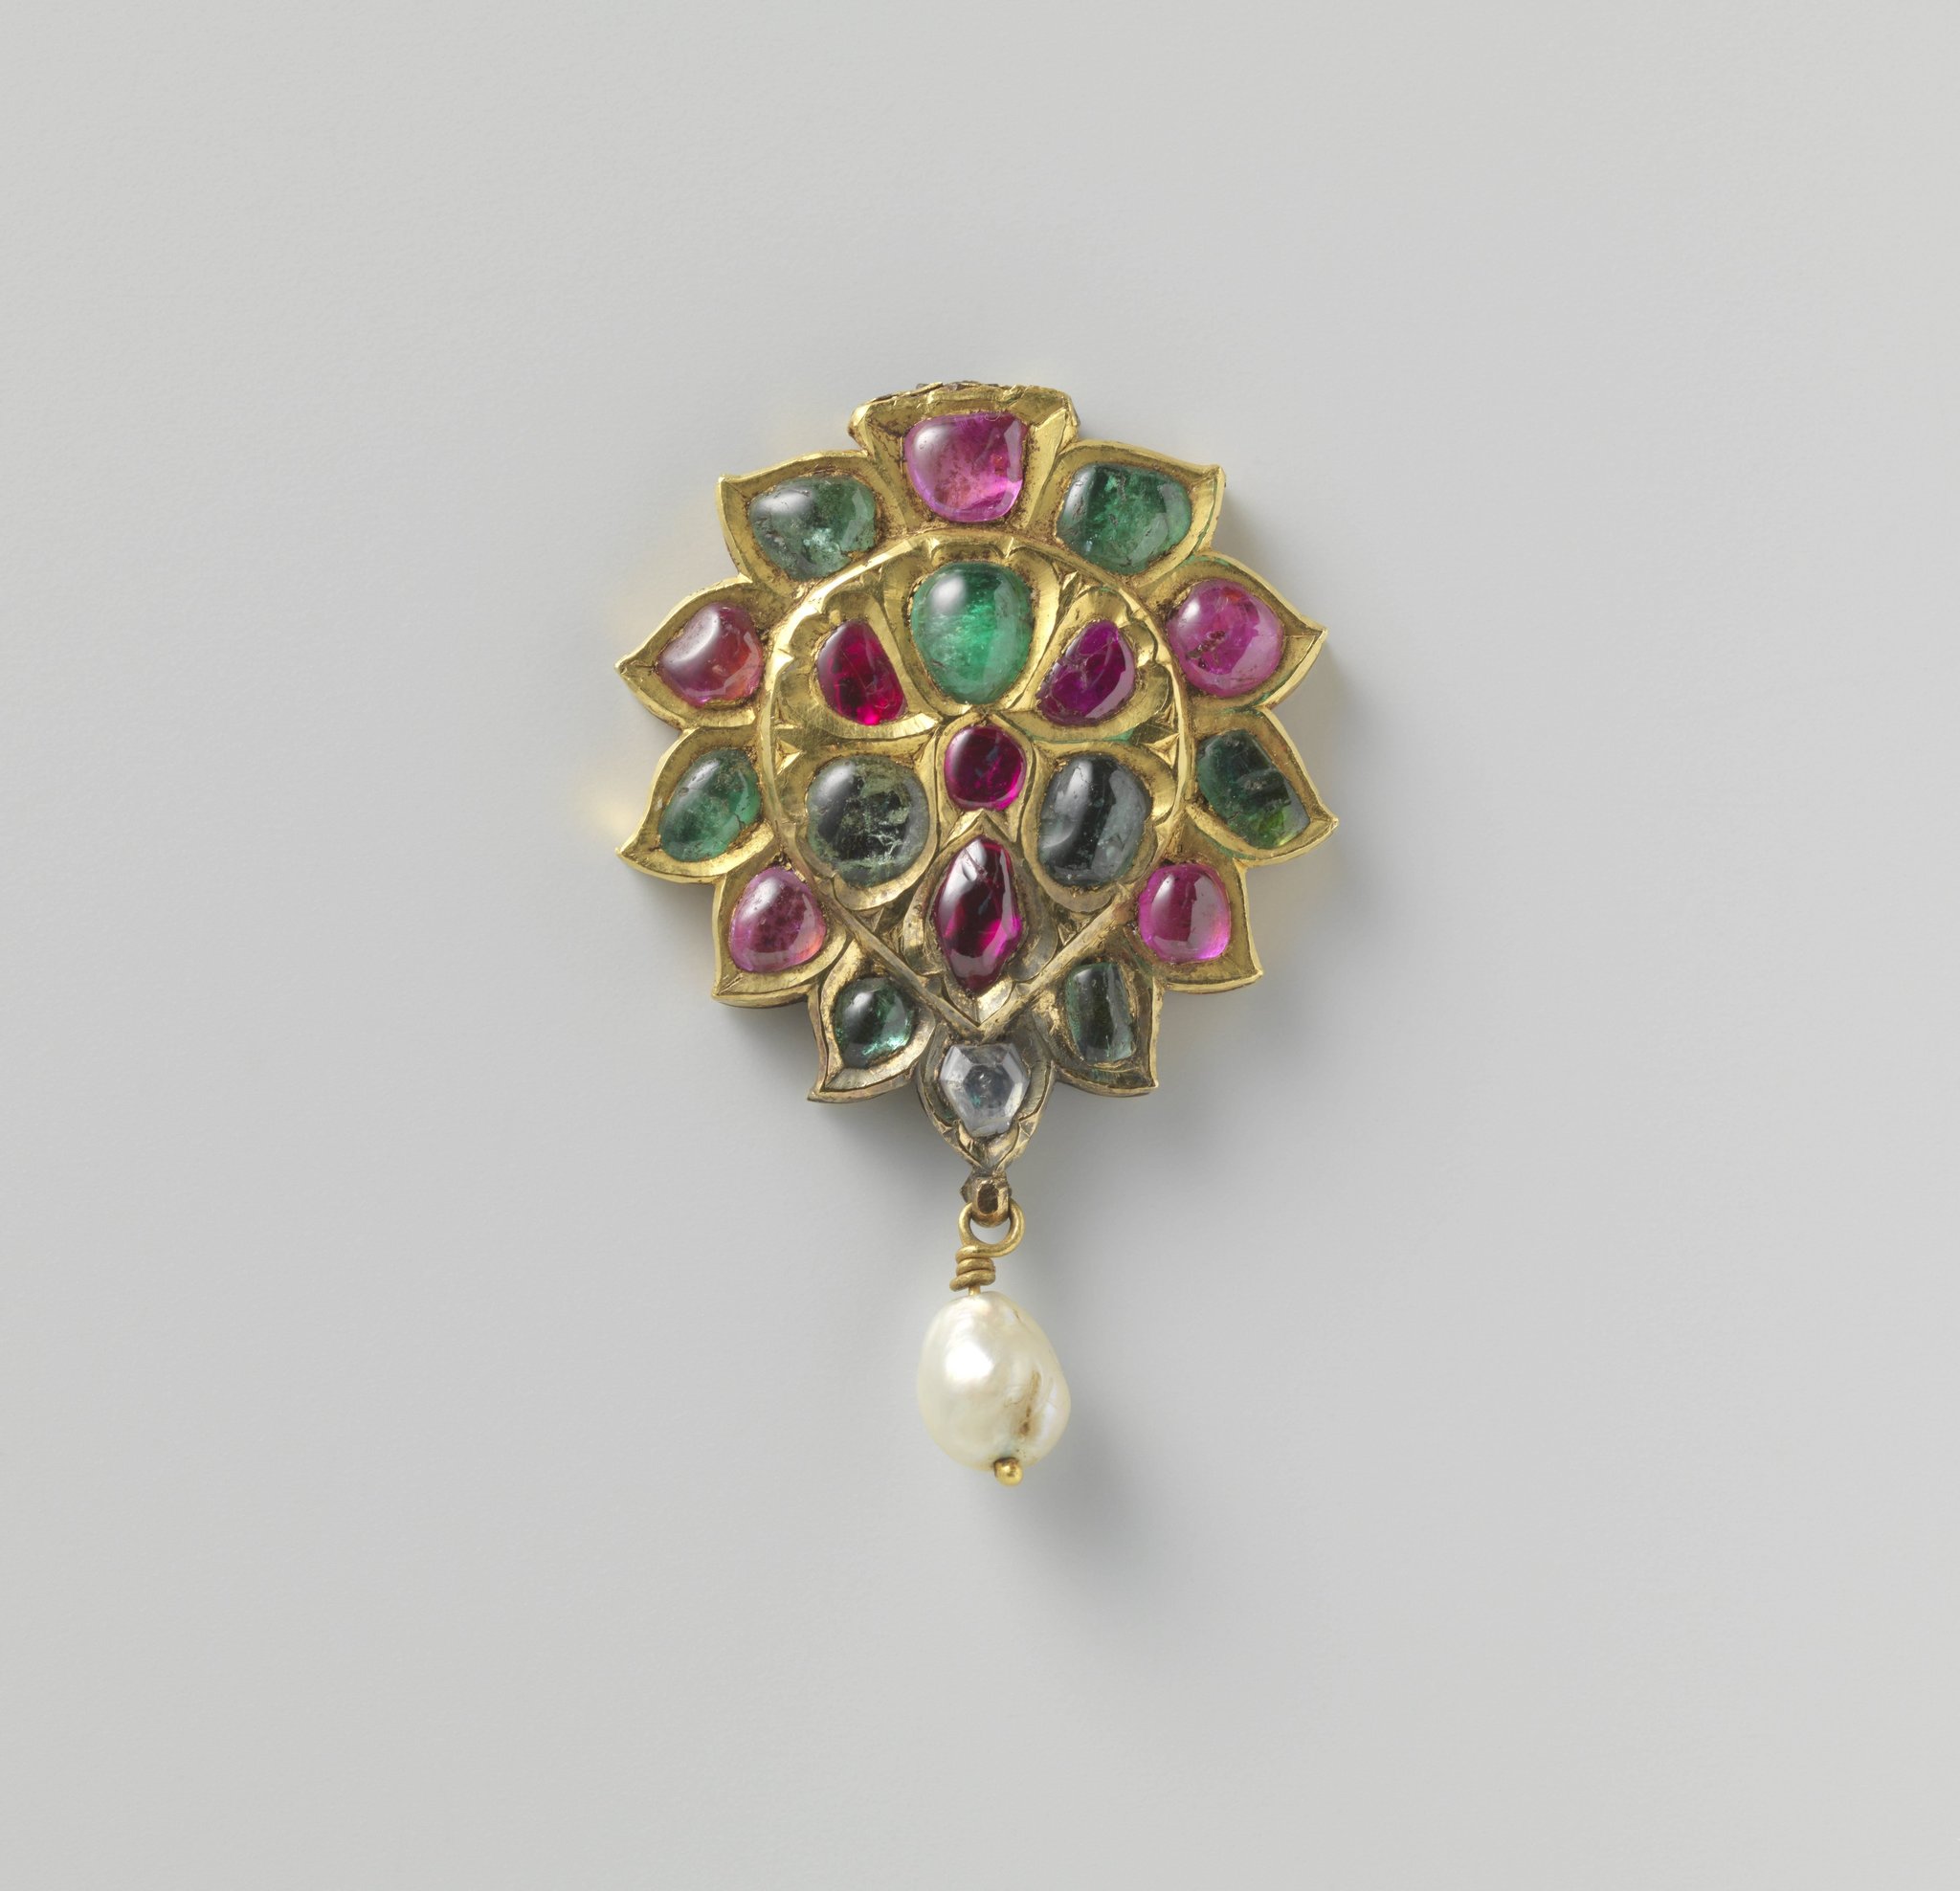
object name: borsthanger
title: Pendant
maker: Anonymous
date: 1750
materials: diamond, gold, pearl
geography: surat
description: Borsthanger (dhukdhuki) in de vorm van een gouden rozet, ingelegd met rode en groene stenen en diamantschilfers. Onderaan hangt een parel.